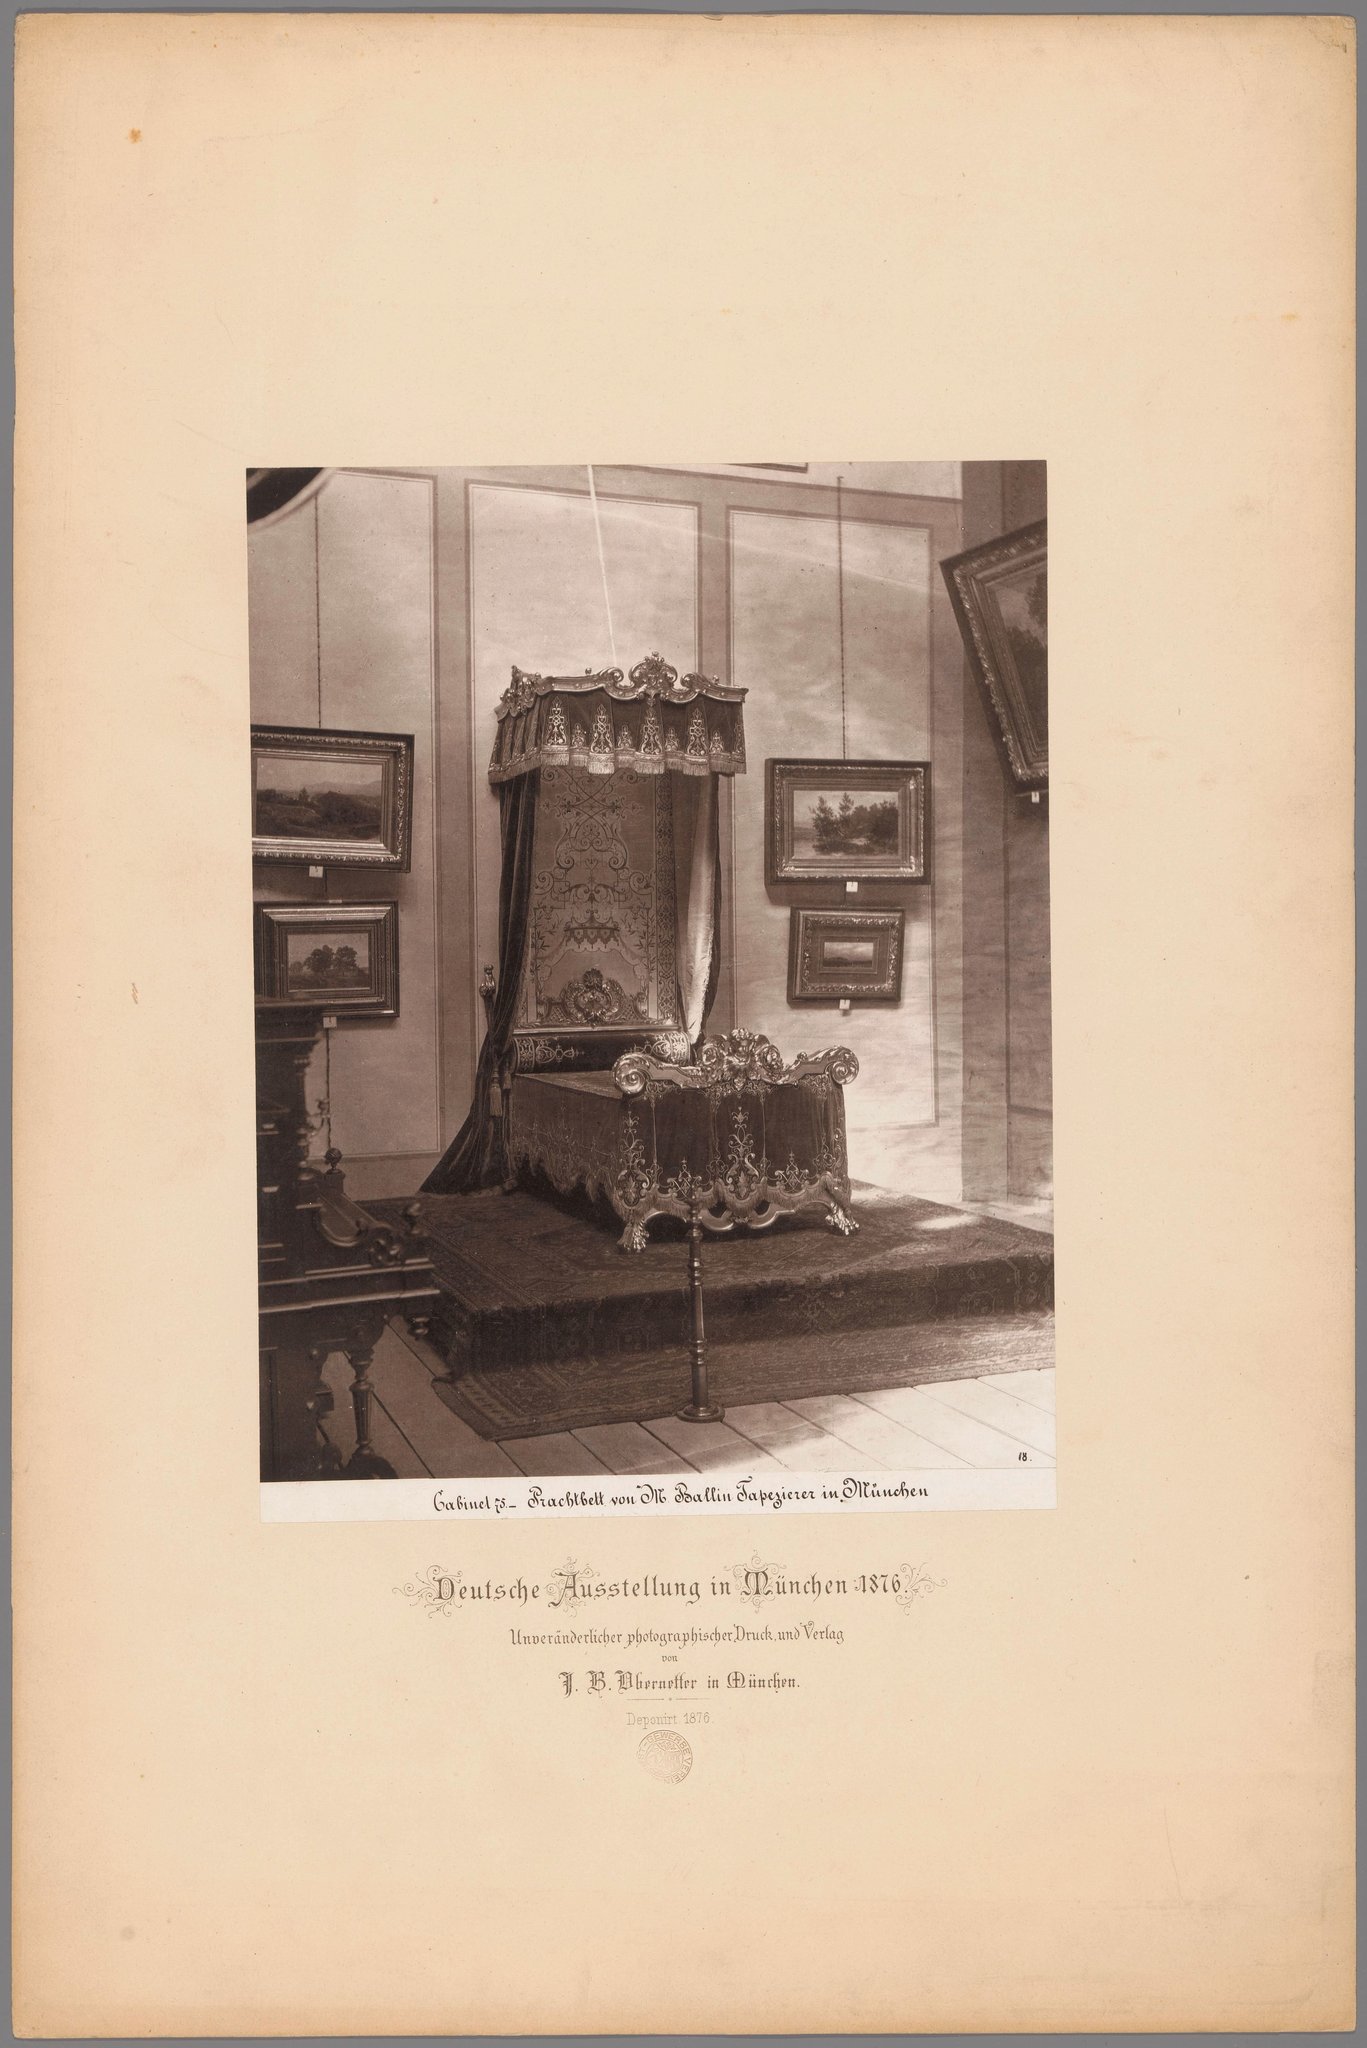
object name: photograph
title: Opstelling van een praalbed in het Bayerisches Nationalmuseum te München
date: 1876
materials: cardboard, paper, ink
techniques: photograph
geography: bayerisches nationalmuseum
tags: bed, interior ~ representation of a building, temporary exhibition, 'salon'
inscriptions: inscription: ‘Deutsche Ausstellung in München 1876. Unveränderlicher photographischer Druck und Verlag von J. B. Obernetter in München. Deponirt 1876.’, number: ‘18.’, inscription: ‘KUNST-GEWERBE VEREIN’, collector's mark: Lugt 3937